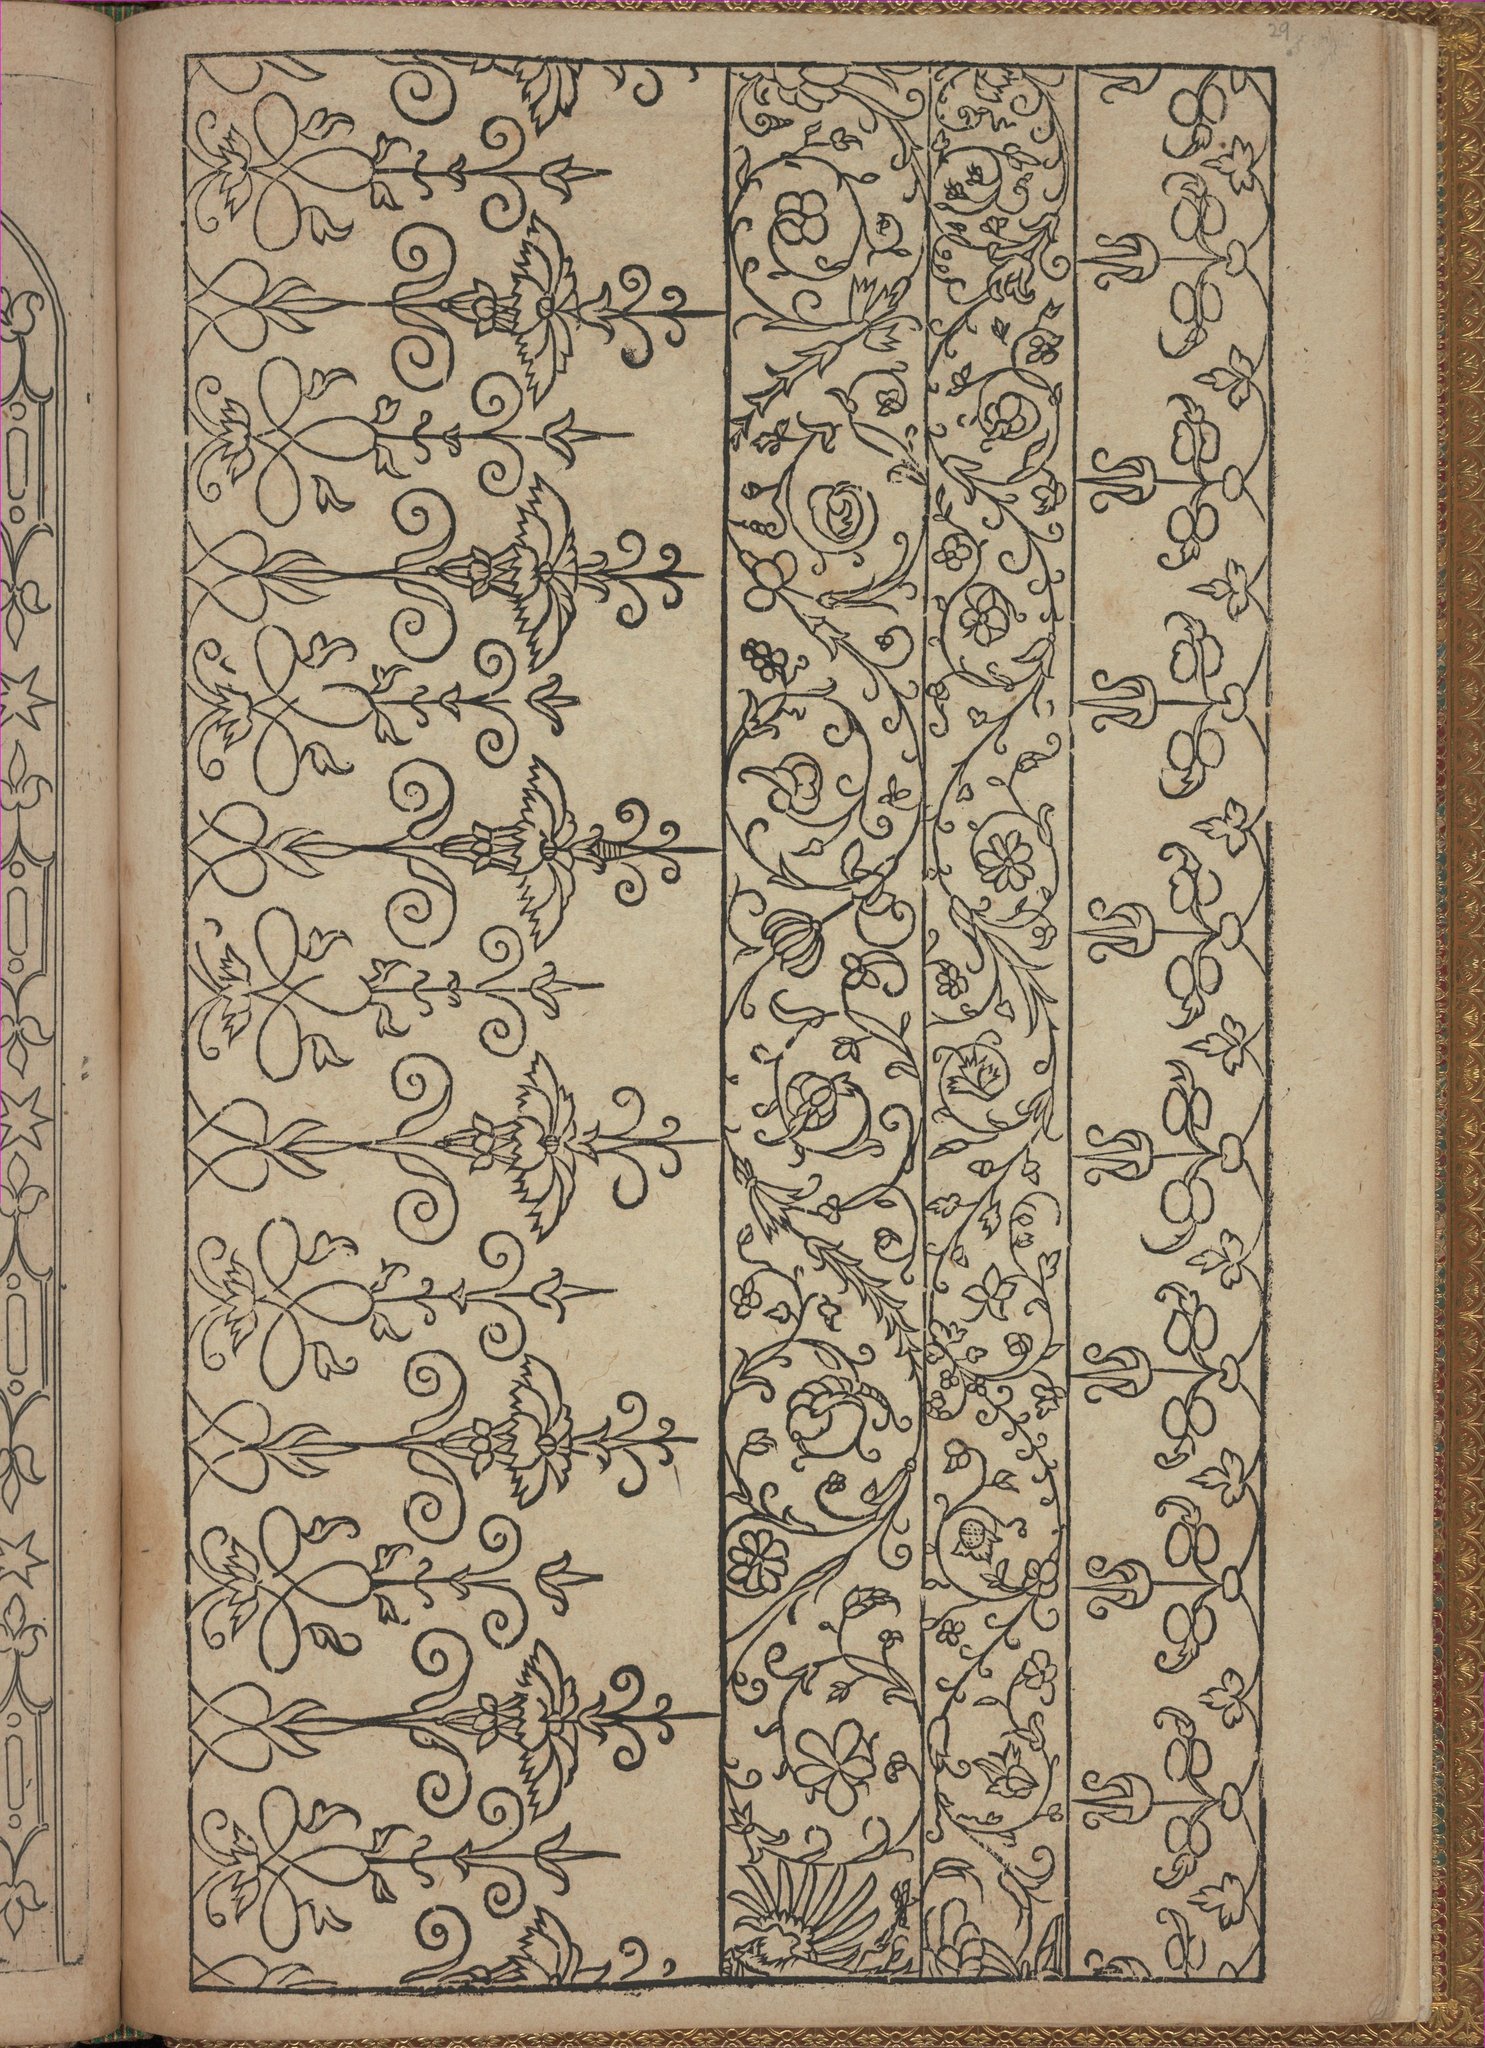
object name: book print ornament architecture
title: New Modelbüch (Page 29r)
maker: andreas bretschneider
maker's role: designer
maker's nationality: german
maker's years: 1573-1645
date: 1615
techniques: woodcut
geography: germany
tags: flowers